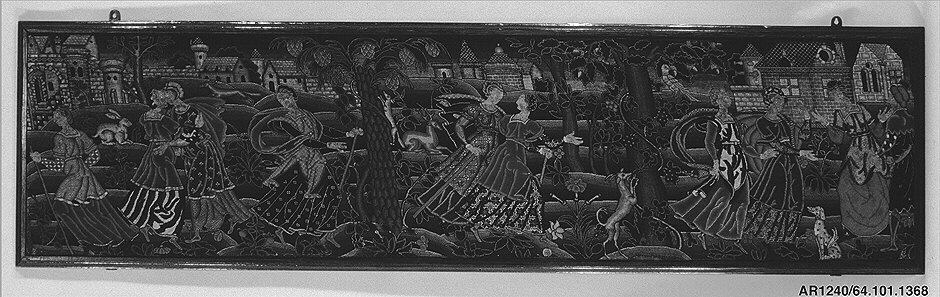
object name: panel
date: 1576-1600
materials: canvas, silk, wool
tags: animals,houses,trees